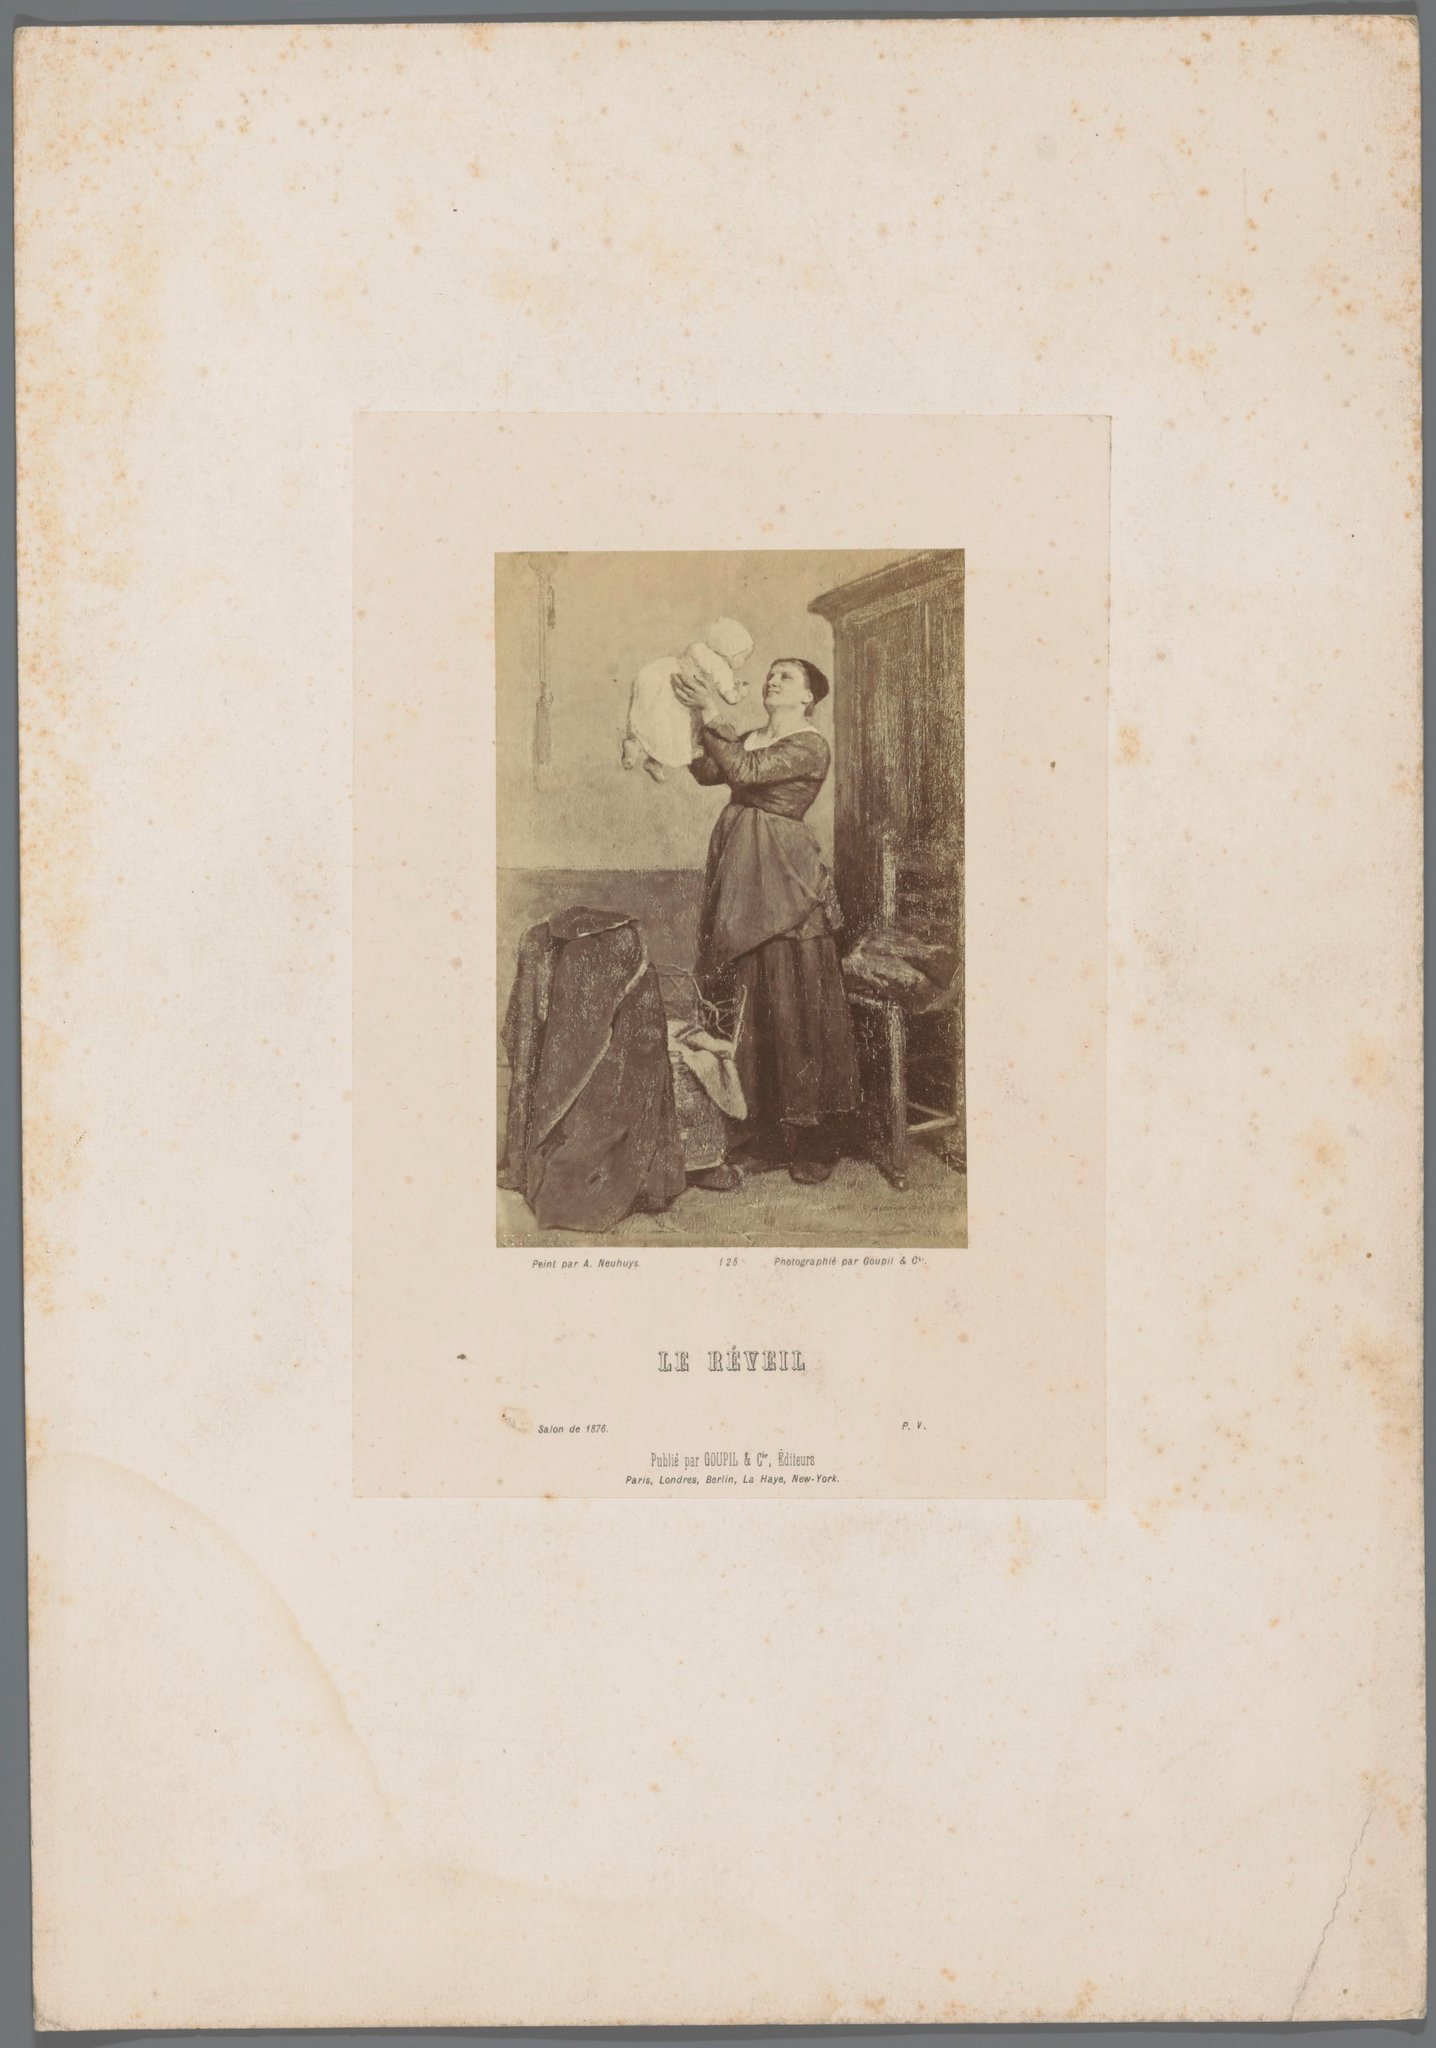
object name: photograph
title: Le Réveil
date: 1850-1900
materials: cardboard, photographic support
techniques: albumen print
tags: adult woman, infant, baby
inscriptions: inscription: ‘Salon de 1876 P.V.’, workshop stamp: ‘Goupil & Cie’